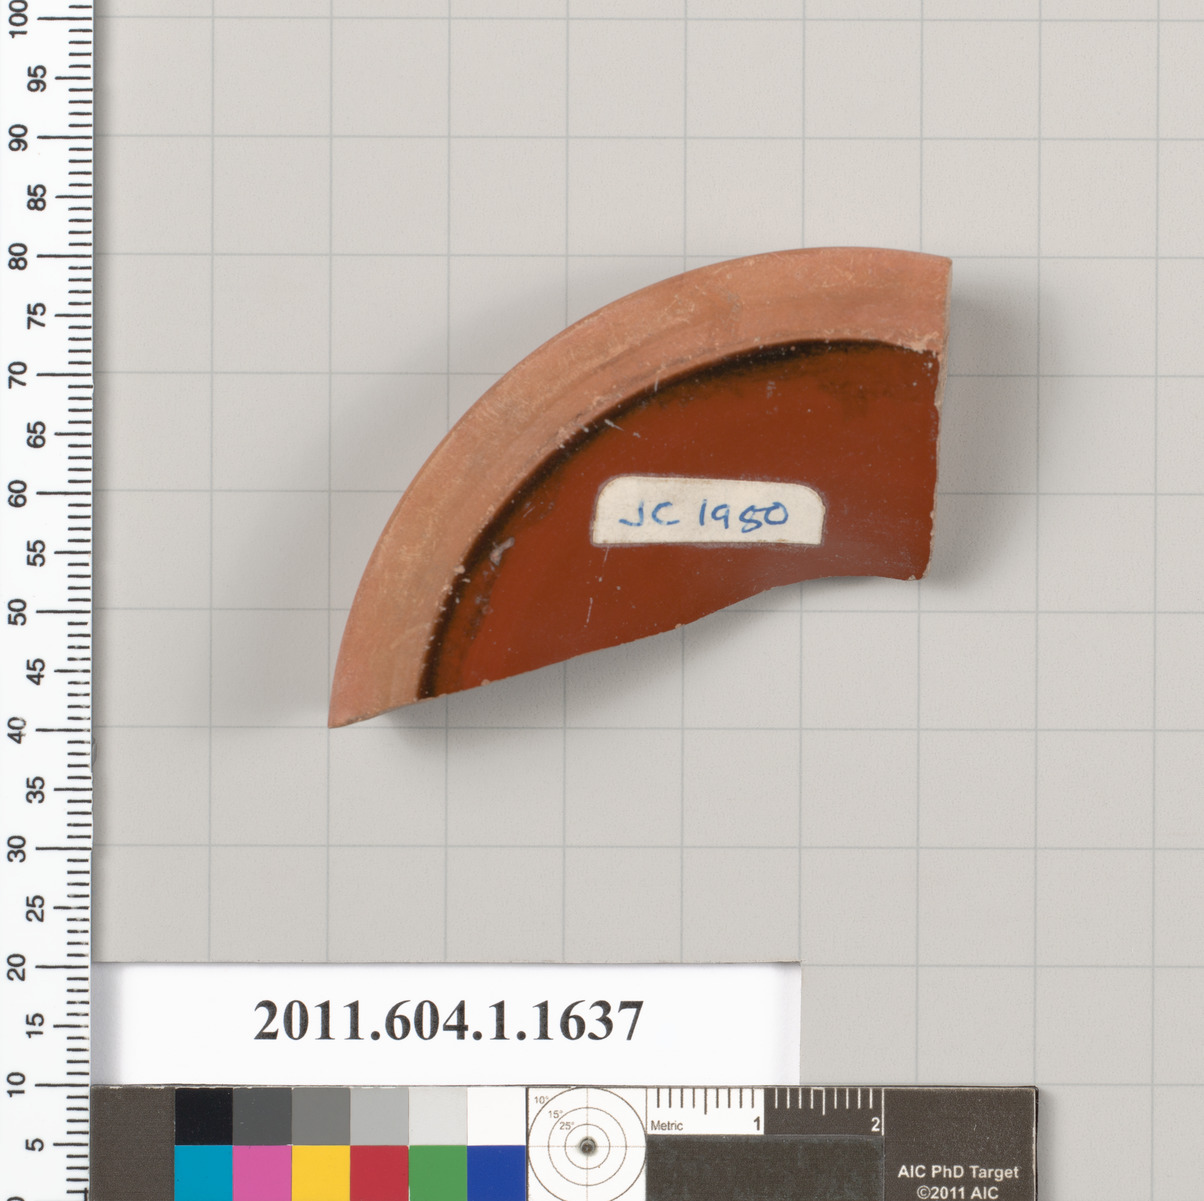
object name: kylix fragment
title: Terracotta fragment of a kylix (drinking cup)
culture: greek, attic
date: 500-401 BCE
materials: terracotta